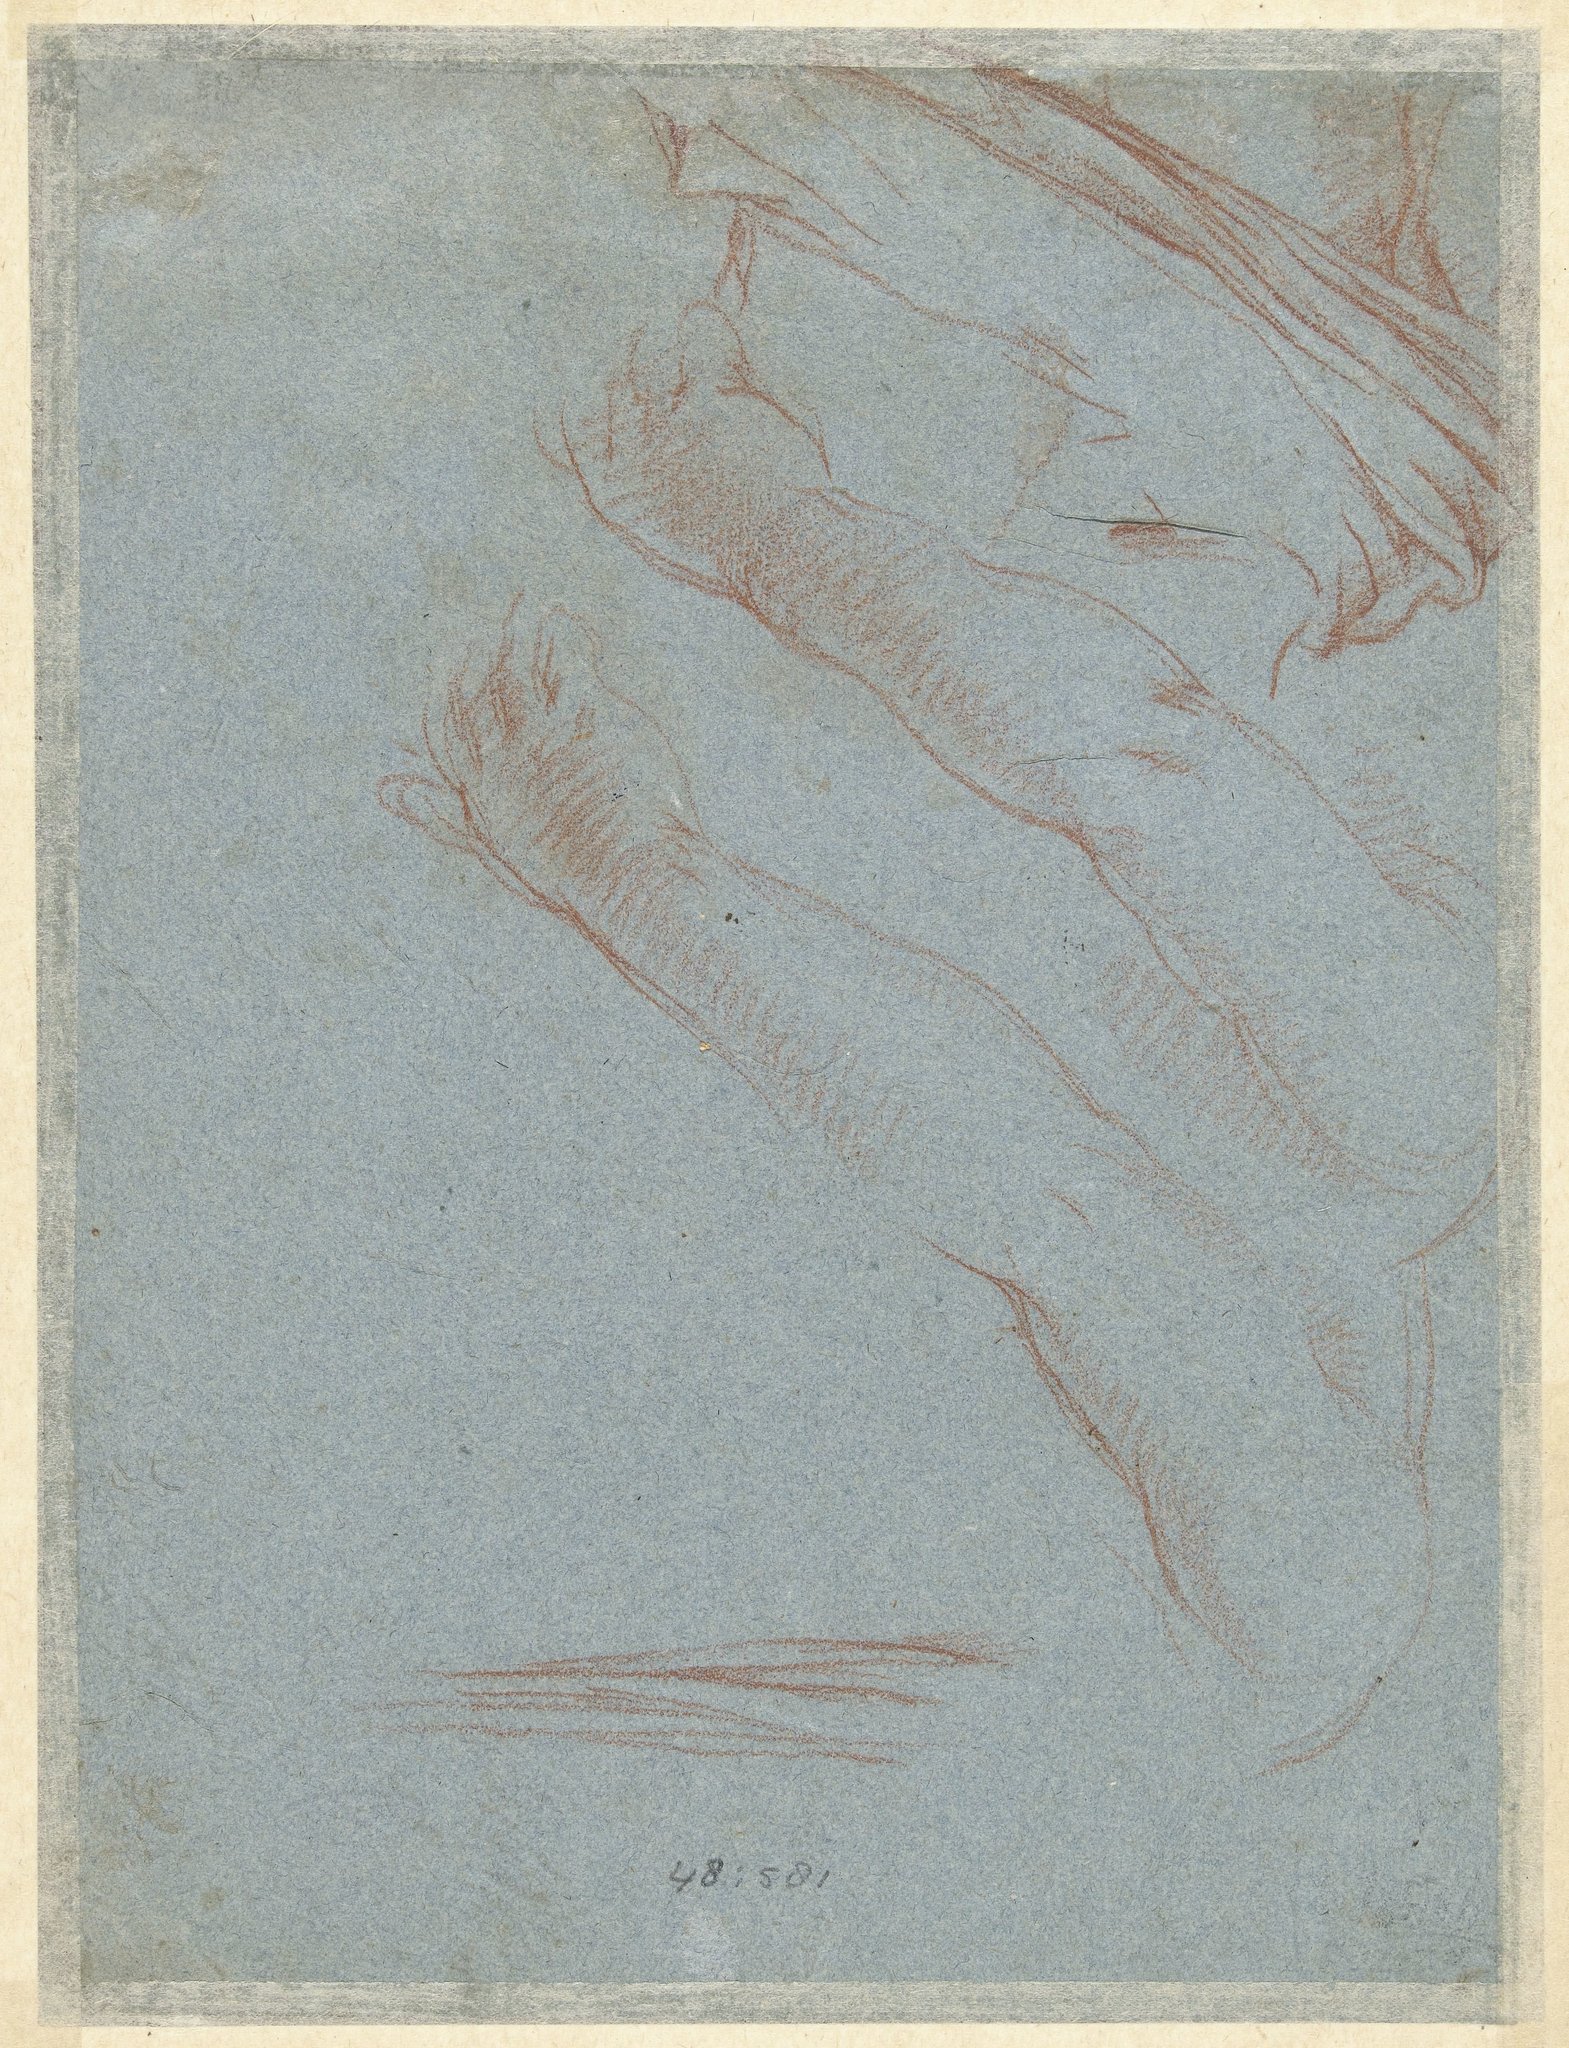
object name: drawing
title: Twee studies van een arm en een kleed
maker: carlo maratta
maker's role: draughtsman, painter, print maker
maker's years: 1625-1713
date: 1635-1713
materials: chalk, paper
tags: arms